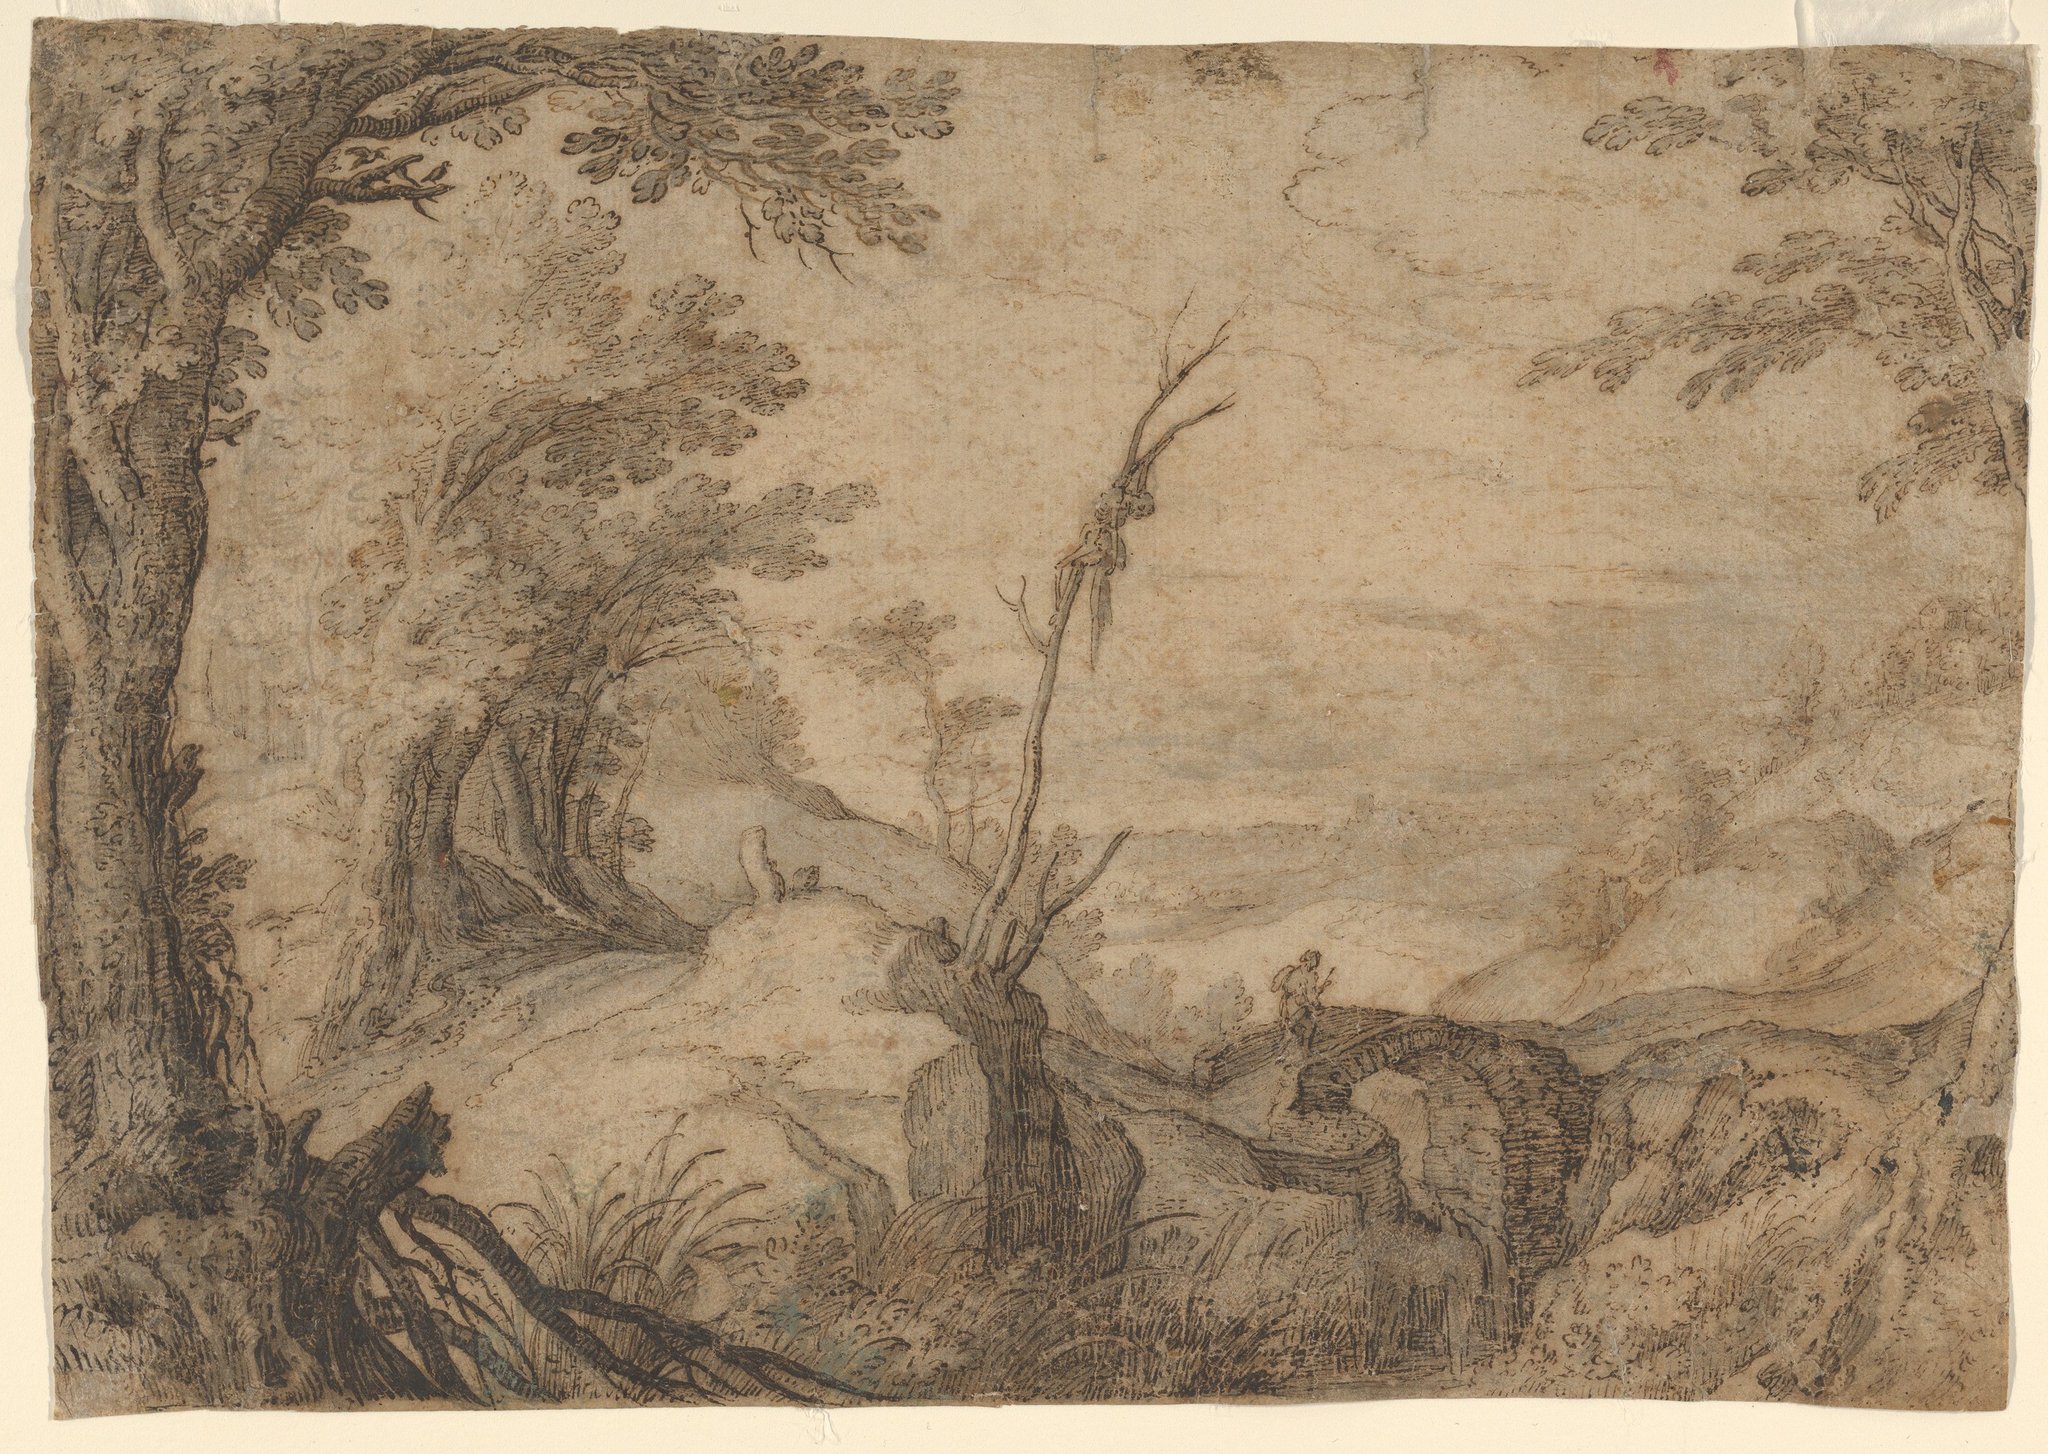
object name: drawing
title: Skeleton Hanging from a Tree in a Landscape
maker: paul bril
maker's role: artist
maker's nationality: netherlandish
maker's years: 1553-1626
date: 1567-1633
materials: chalk, ink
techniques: brush, pen, wash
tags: skeletons,landscapes,trees